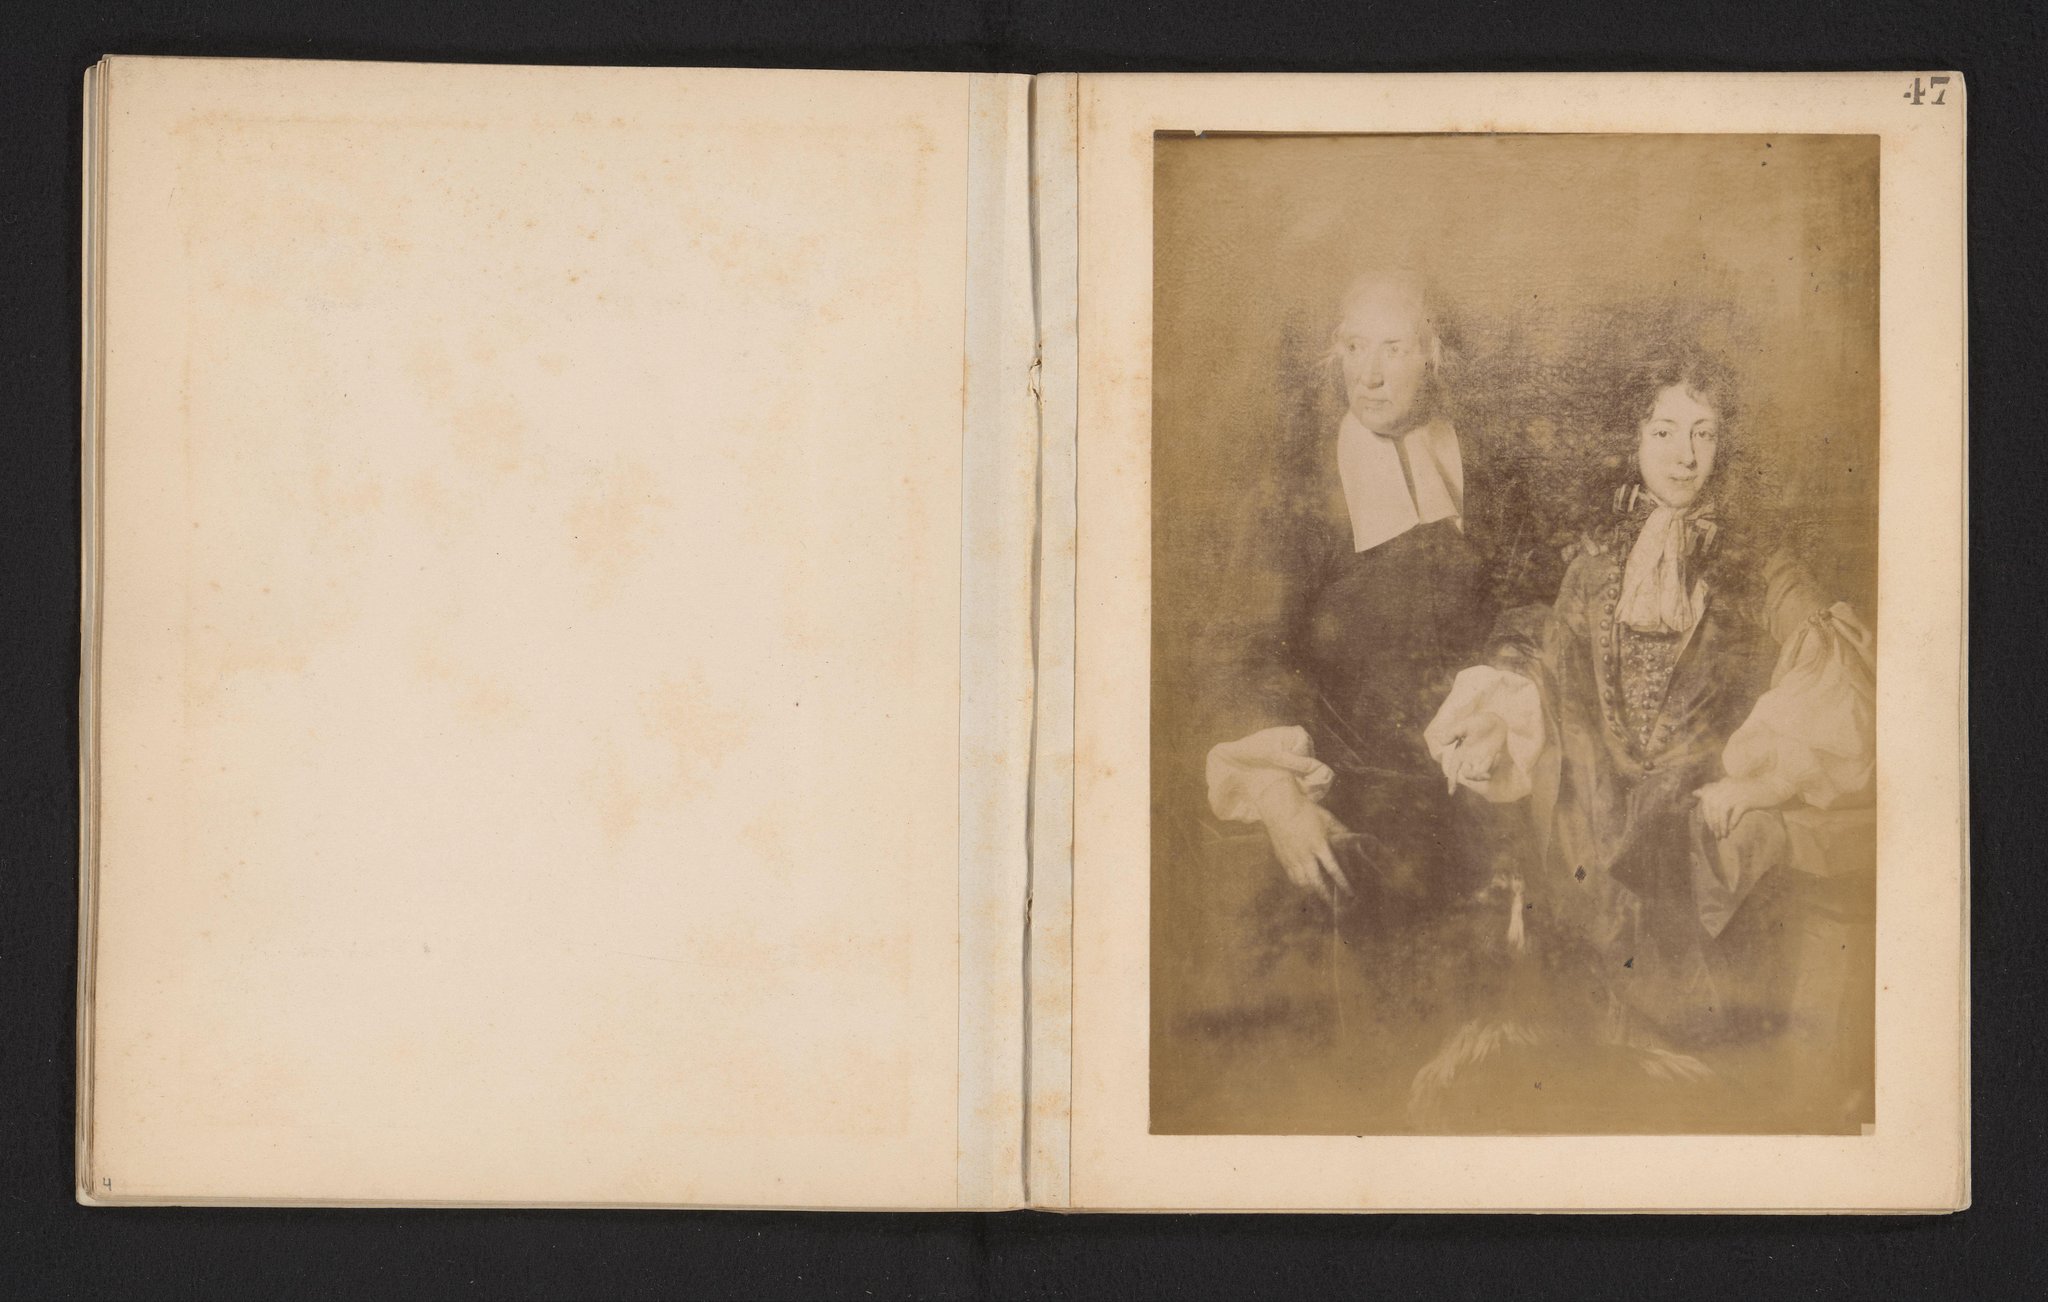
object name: page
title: Fotoreproductie van een schilderij van een portret van Lodewijk, dauphin van Frankrijk en zijn zoon Lodewijk van Frankrijk door Nicolas de Largillière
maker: Anonymous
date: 1882-1887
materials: photographic support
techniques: albumen print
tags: lodewijk van frankrijk (hertog van bourgondië), dauphin van frankrijk lodewijk, aristocracy; 'aristocratia' (ripa), historical persons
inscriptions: number: ‘47’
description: Foto op vijfde ongenummerde pagina na pagina 18.